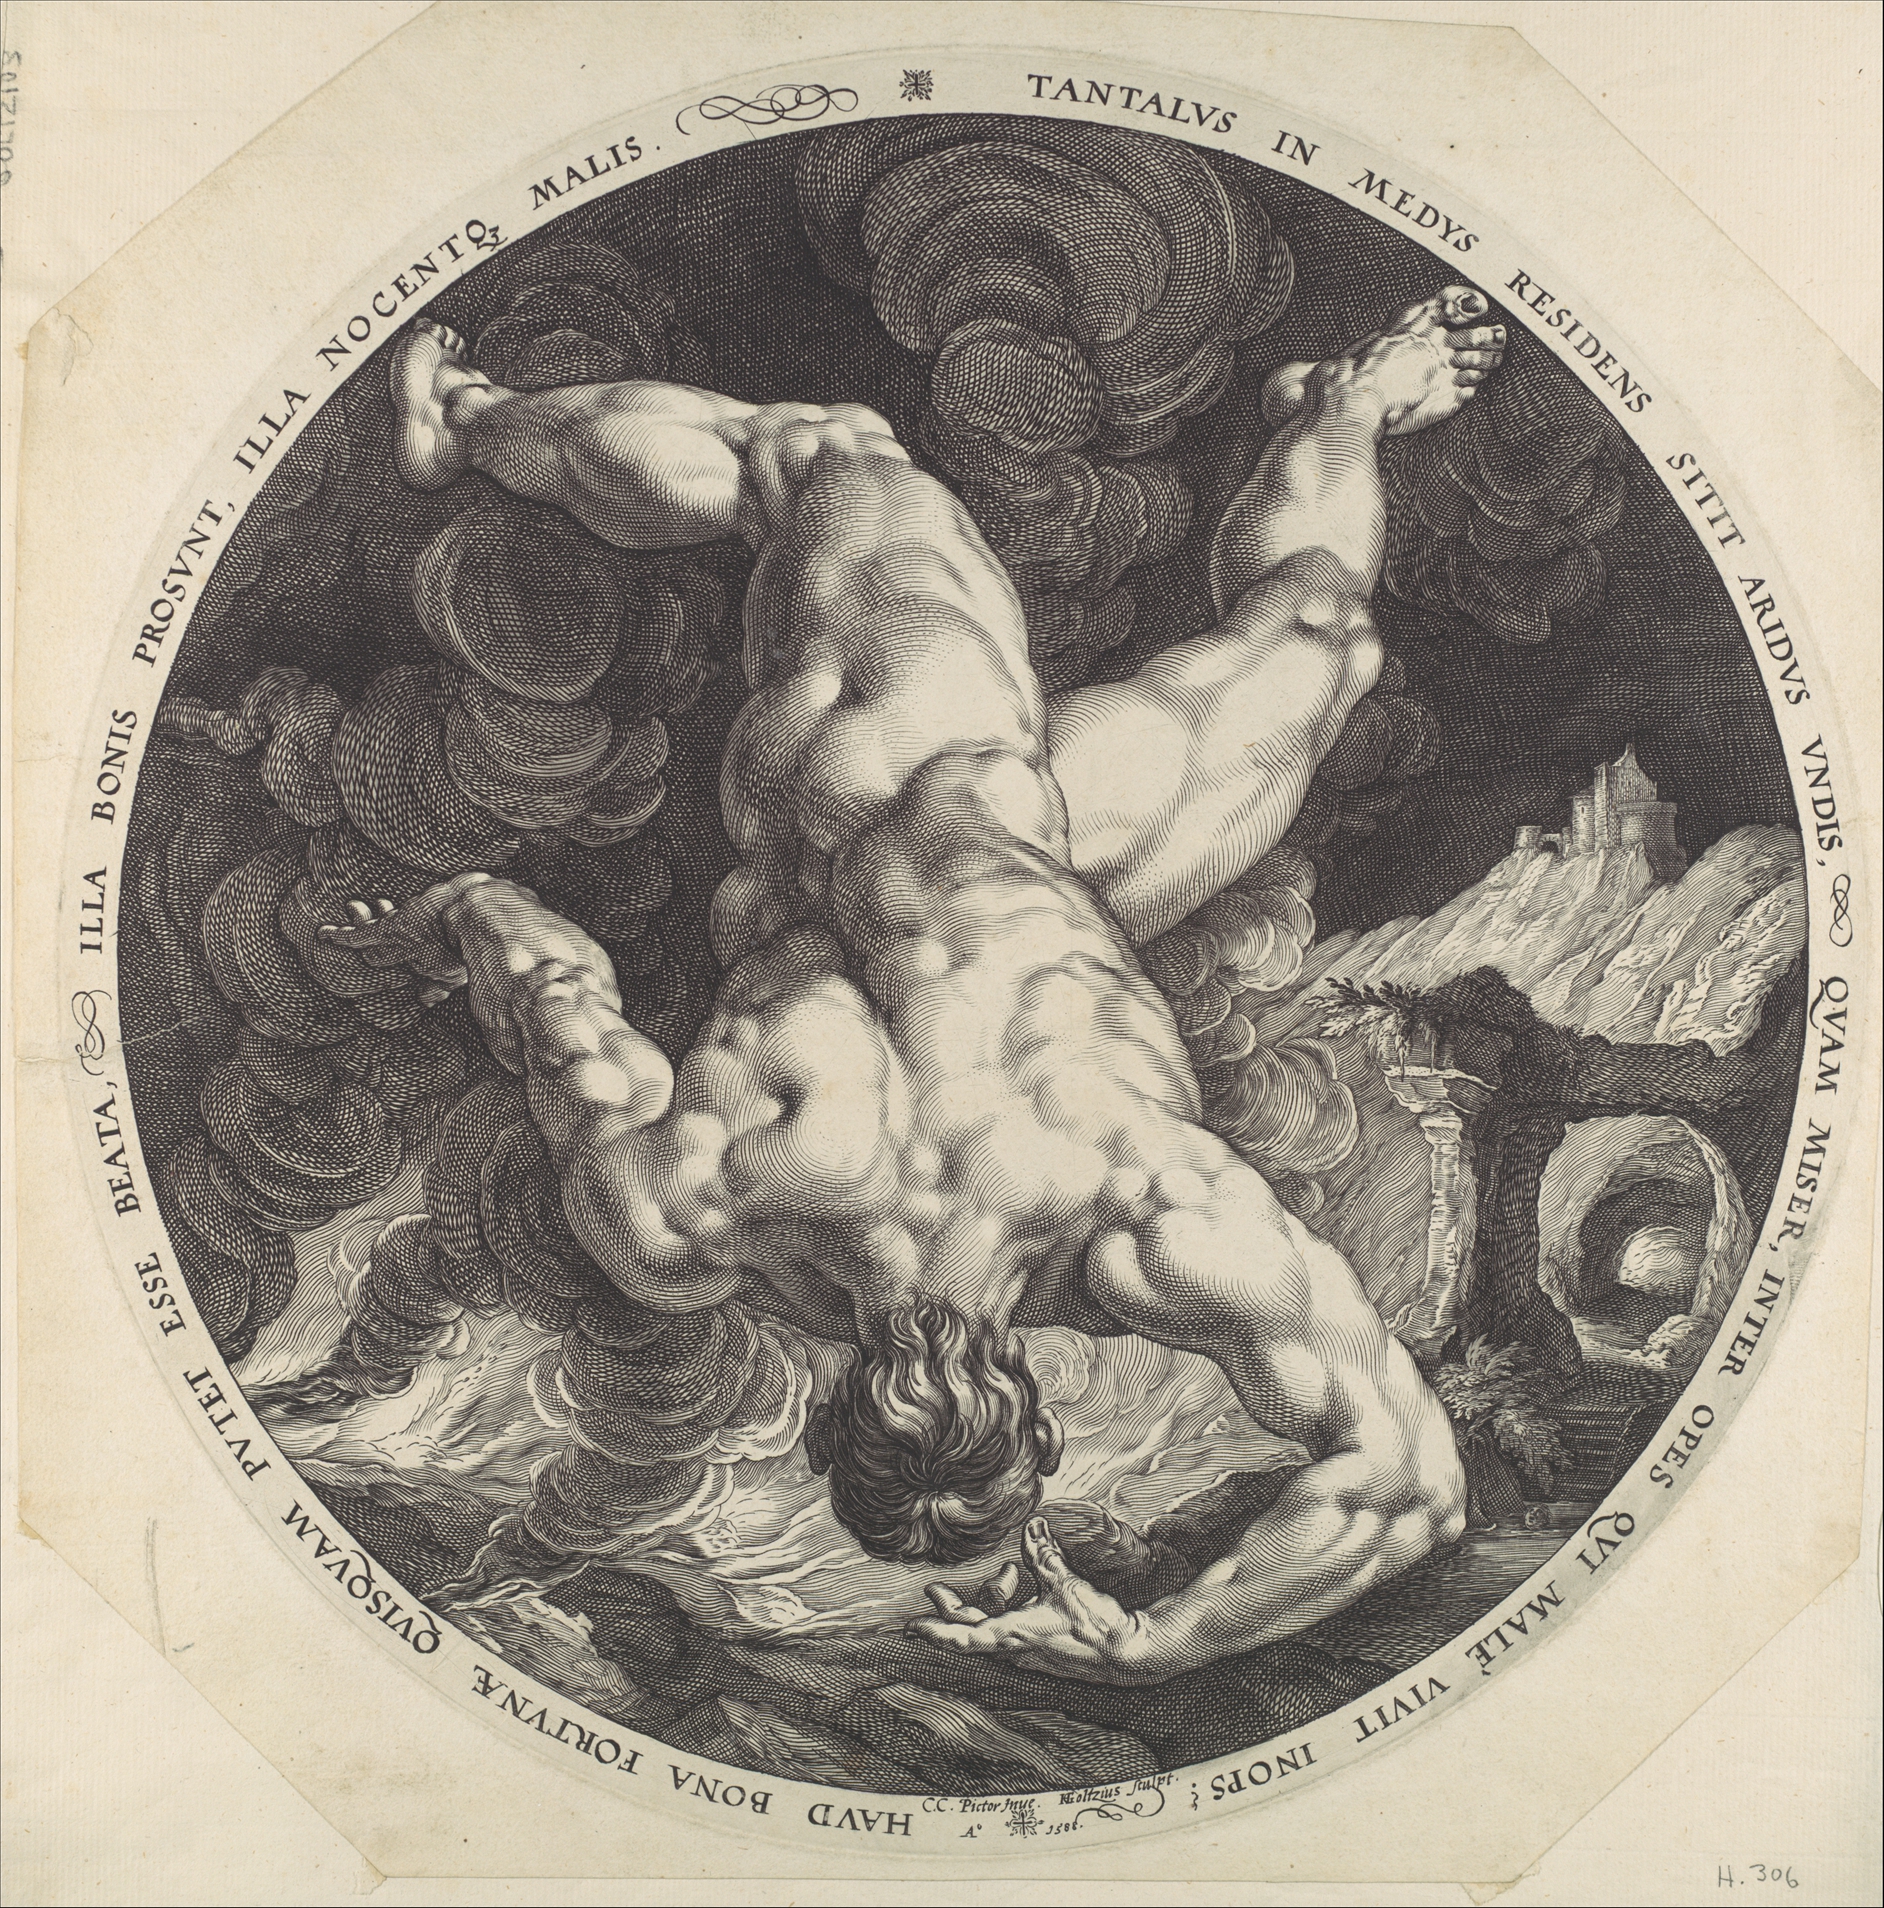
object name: print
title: Tantalus, from "The Four Disgracers"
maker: hendrick goltzius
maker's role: artist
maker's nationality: netherlandish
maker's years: 1558-1617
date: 1588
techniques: engraving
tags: male nudes